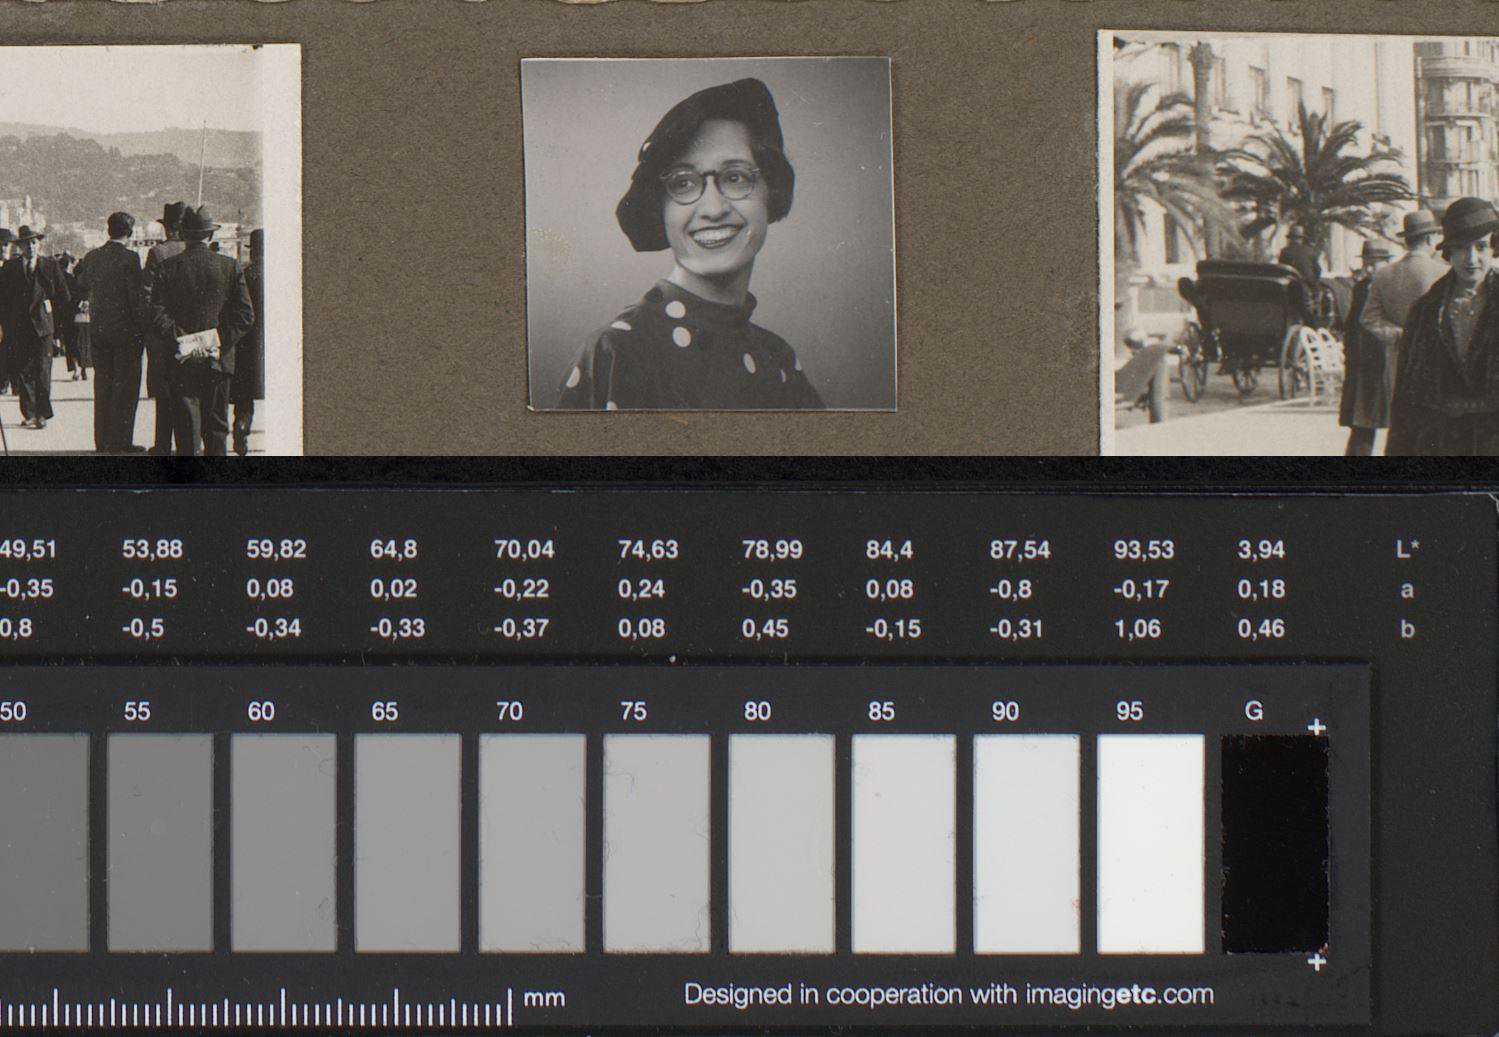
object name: photograph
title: Portret van Dootje met een baret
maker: Anonymous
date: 1934-1935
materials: paper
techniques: gelatin silver print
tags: historical persons - bb - woman, head-gear: beret